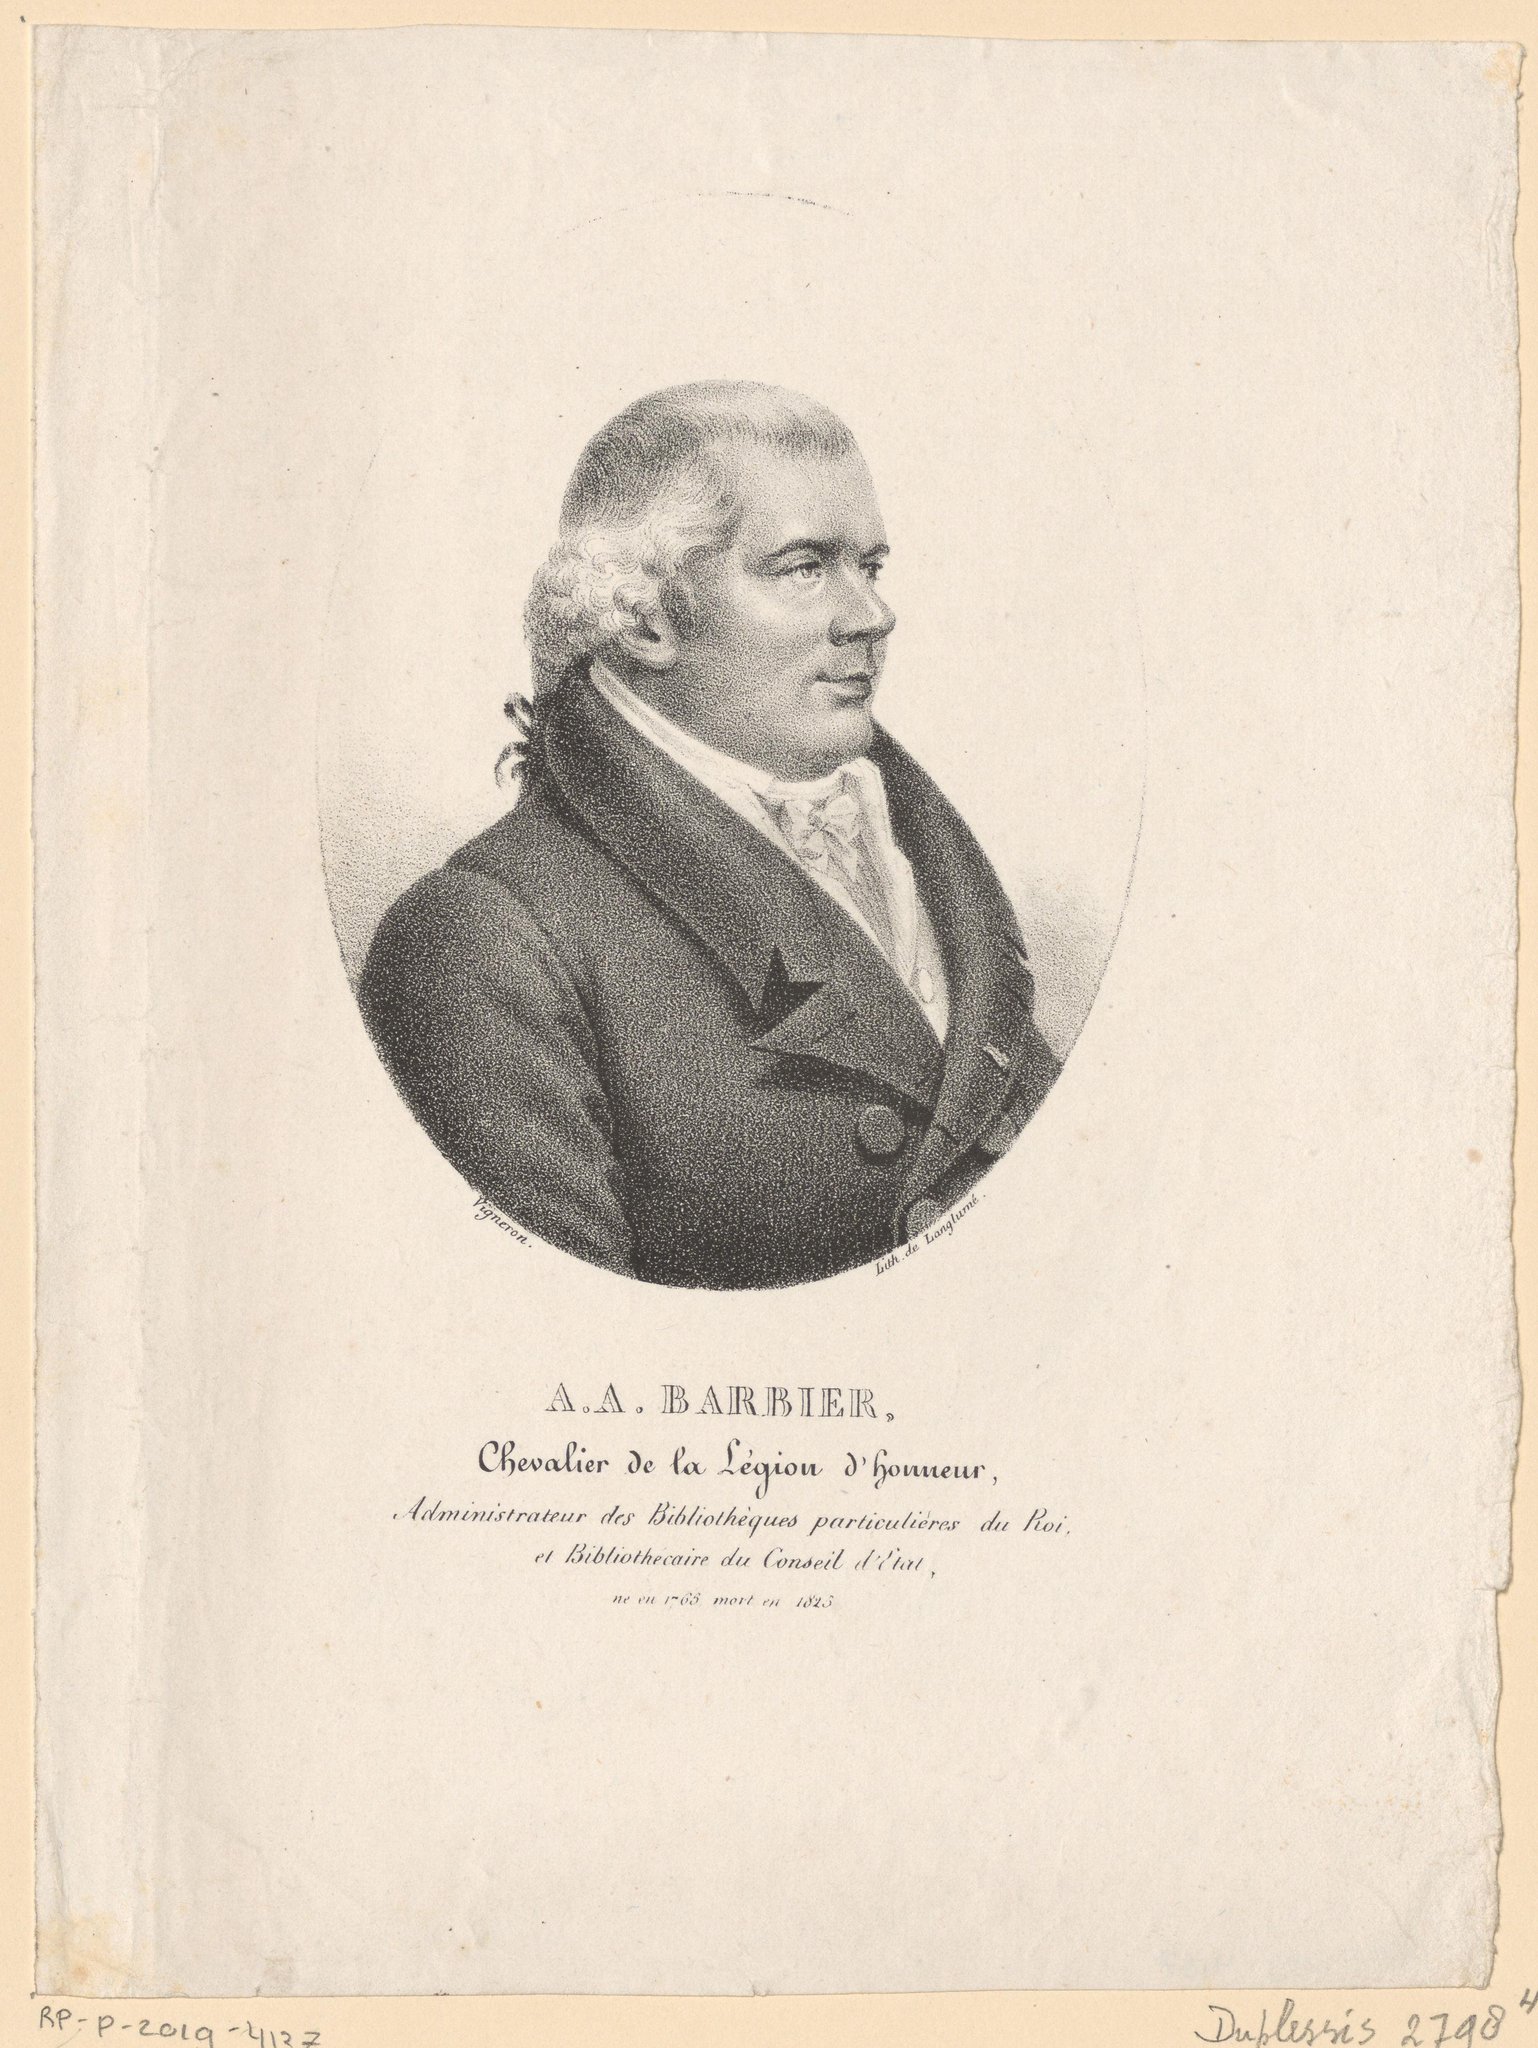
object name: print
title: Portret van Antoine-Alexandre Barbier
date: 1825-1830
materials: paper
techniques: lithograph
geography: paris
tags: paris, historical persons